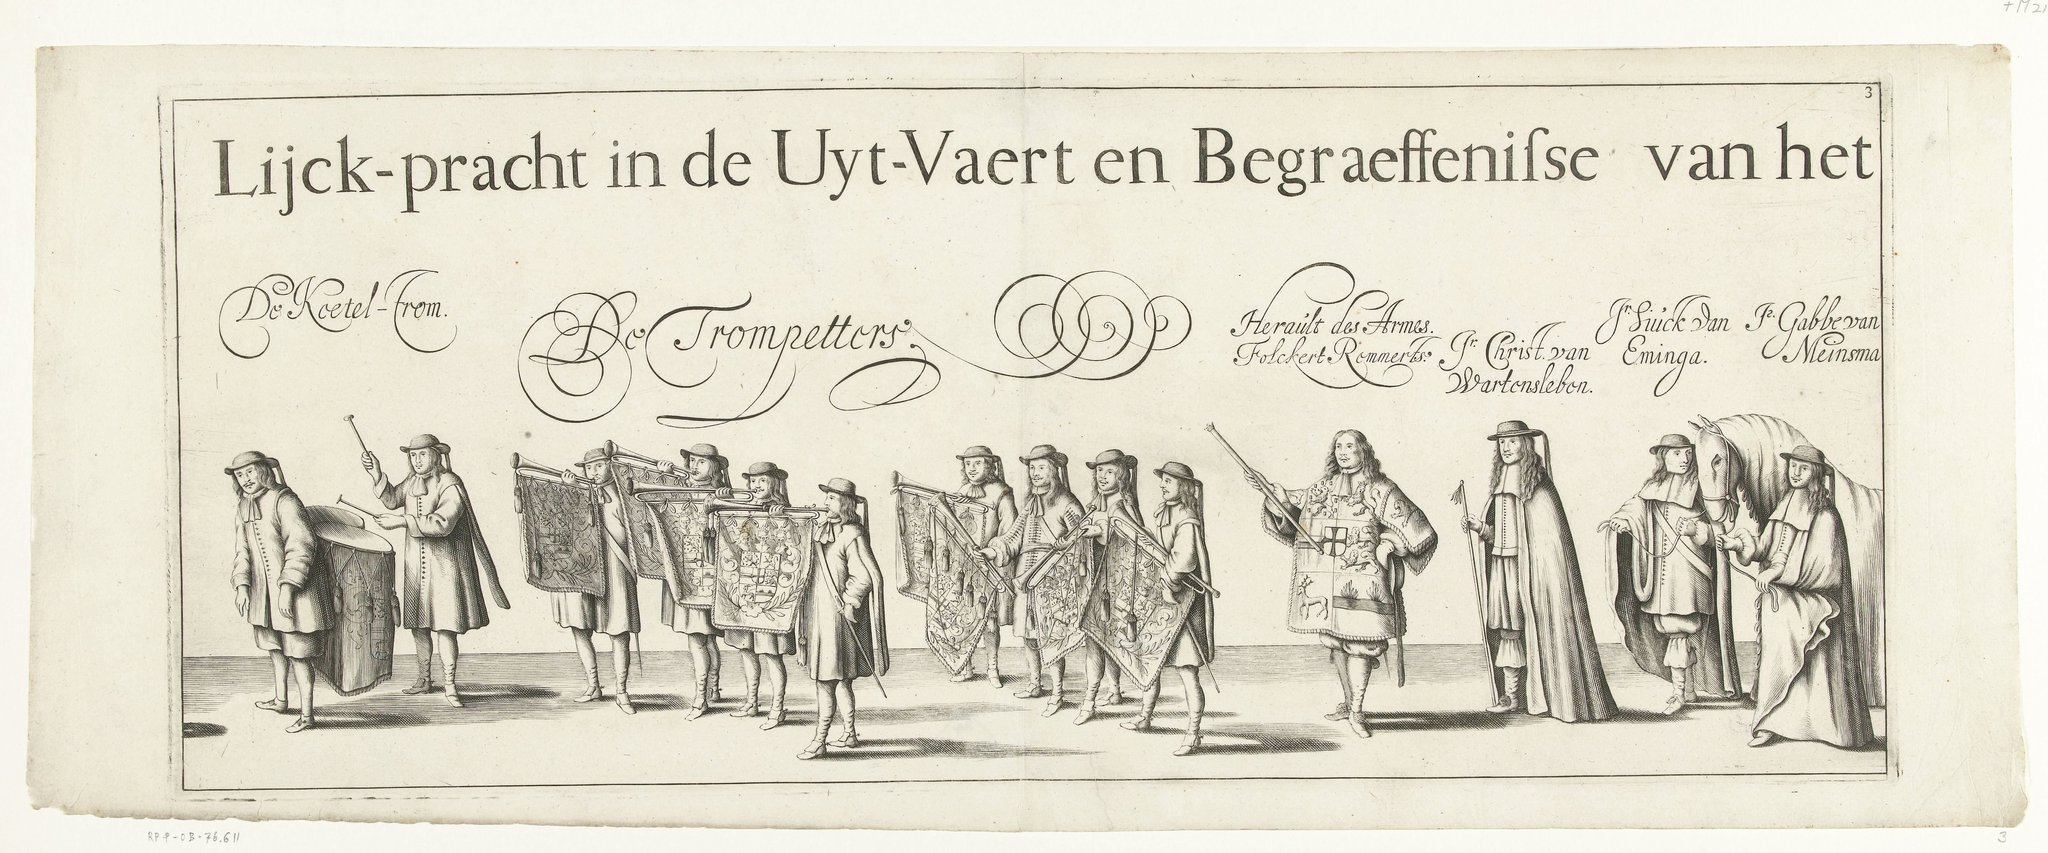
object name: print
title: Begrafenisoptocht van Willem Frederik, graaf van Nassau-Dietz (blad 3), 1665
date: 1666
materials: paper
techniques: engraving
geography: leeuwarden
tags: arnhem, cortege, funeral procession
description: Begrafenisoptocht van Willem Frederik, graaf van Nassau-Dietz, in Leeuwarden op 6 januari 1665. Deel van de begrafenisstoet. Plaat nr. 3 in een ensemble van 25 ongemonteerde genummerde platen en twee tekstbladen die samen een lange fries vormen.